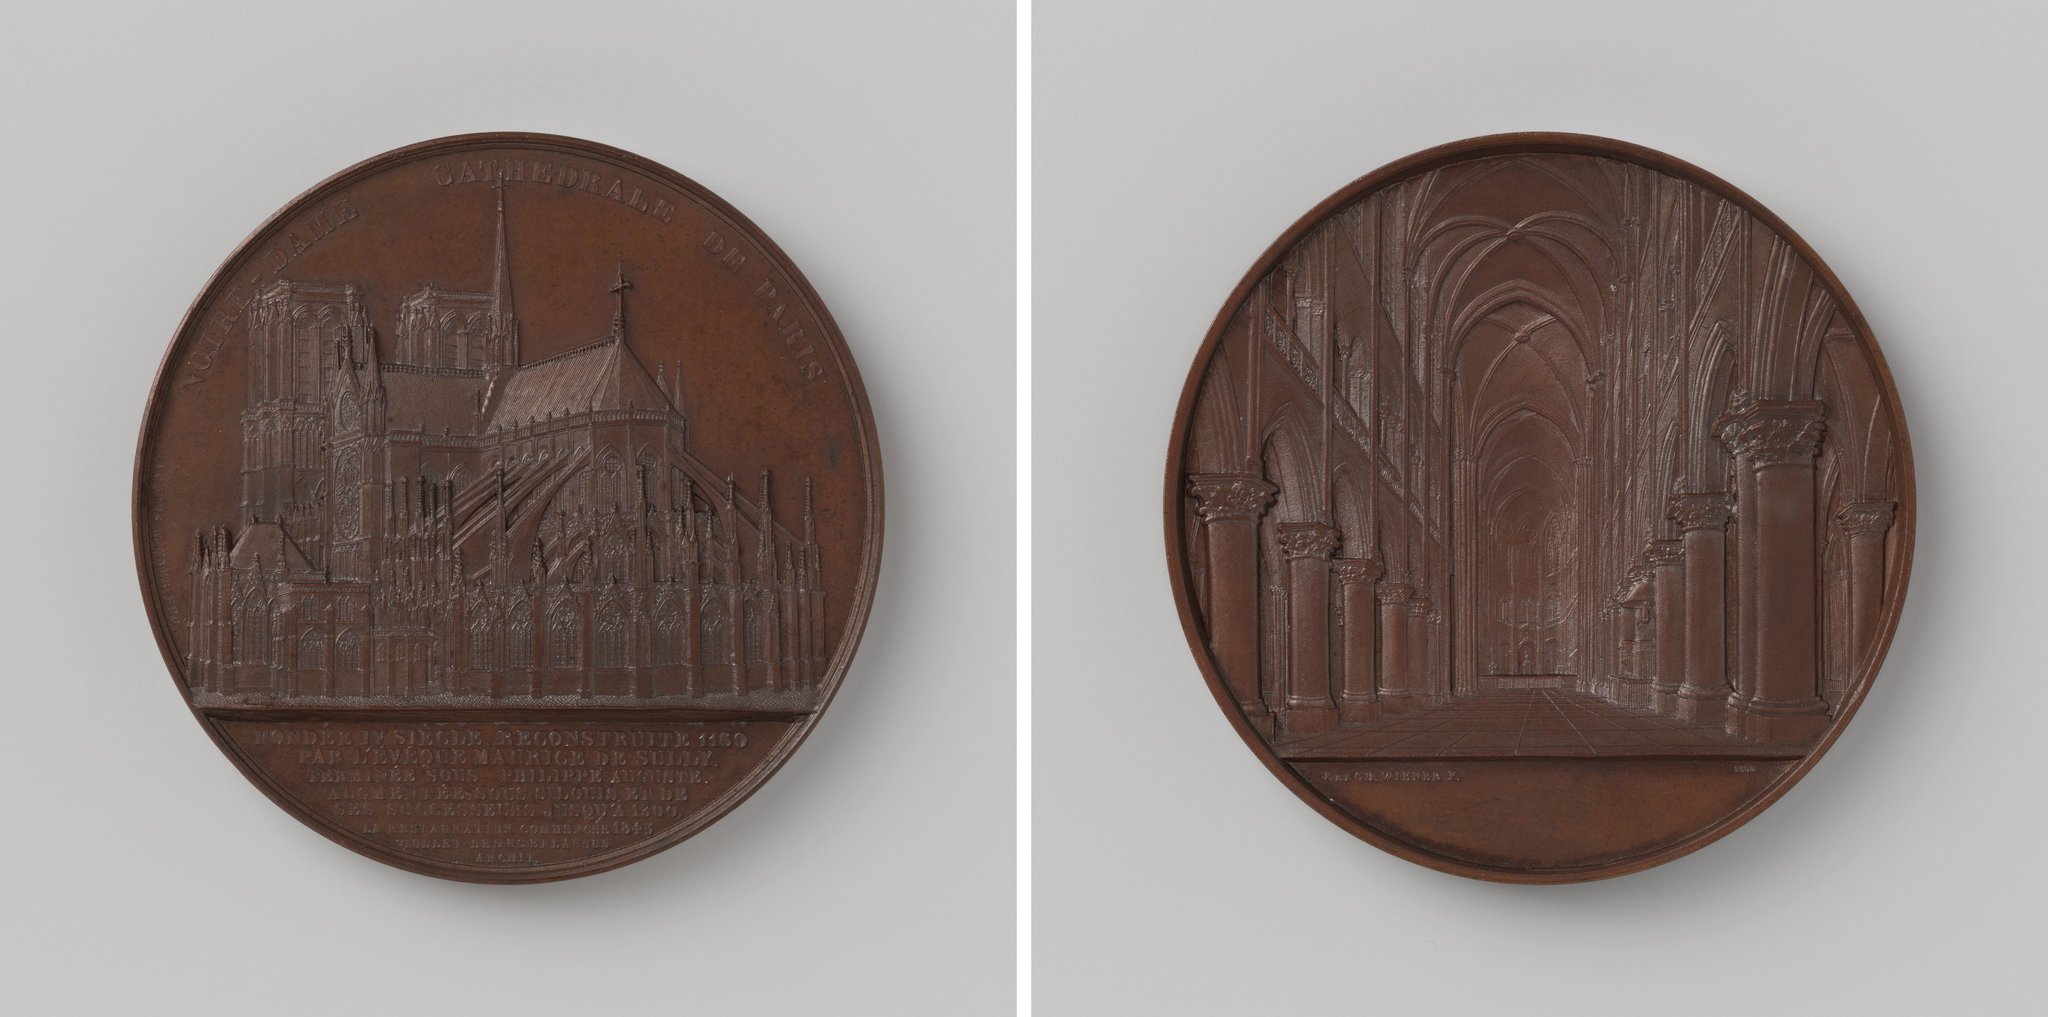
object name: history medal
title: Notre Dame te Parijs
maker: jacob wiener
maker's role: medailleur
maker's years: 1815-1899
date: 1855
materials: bronze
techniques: striking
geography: brussels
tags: notre-dame